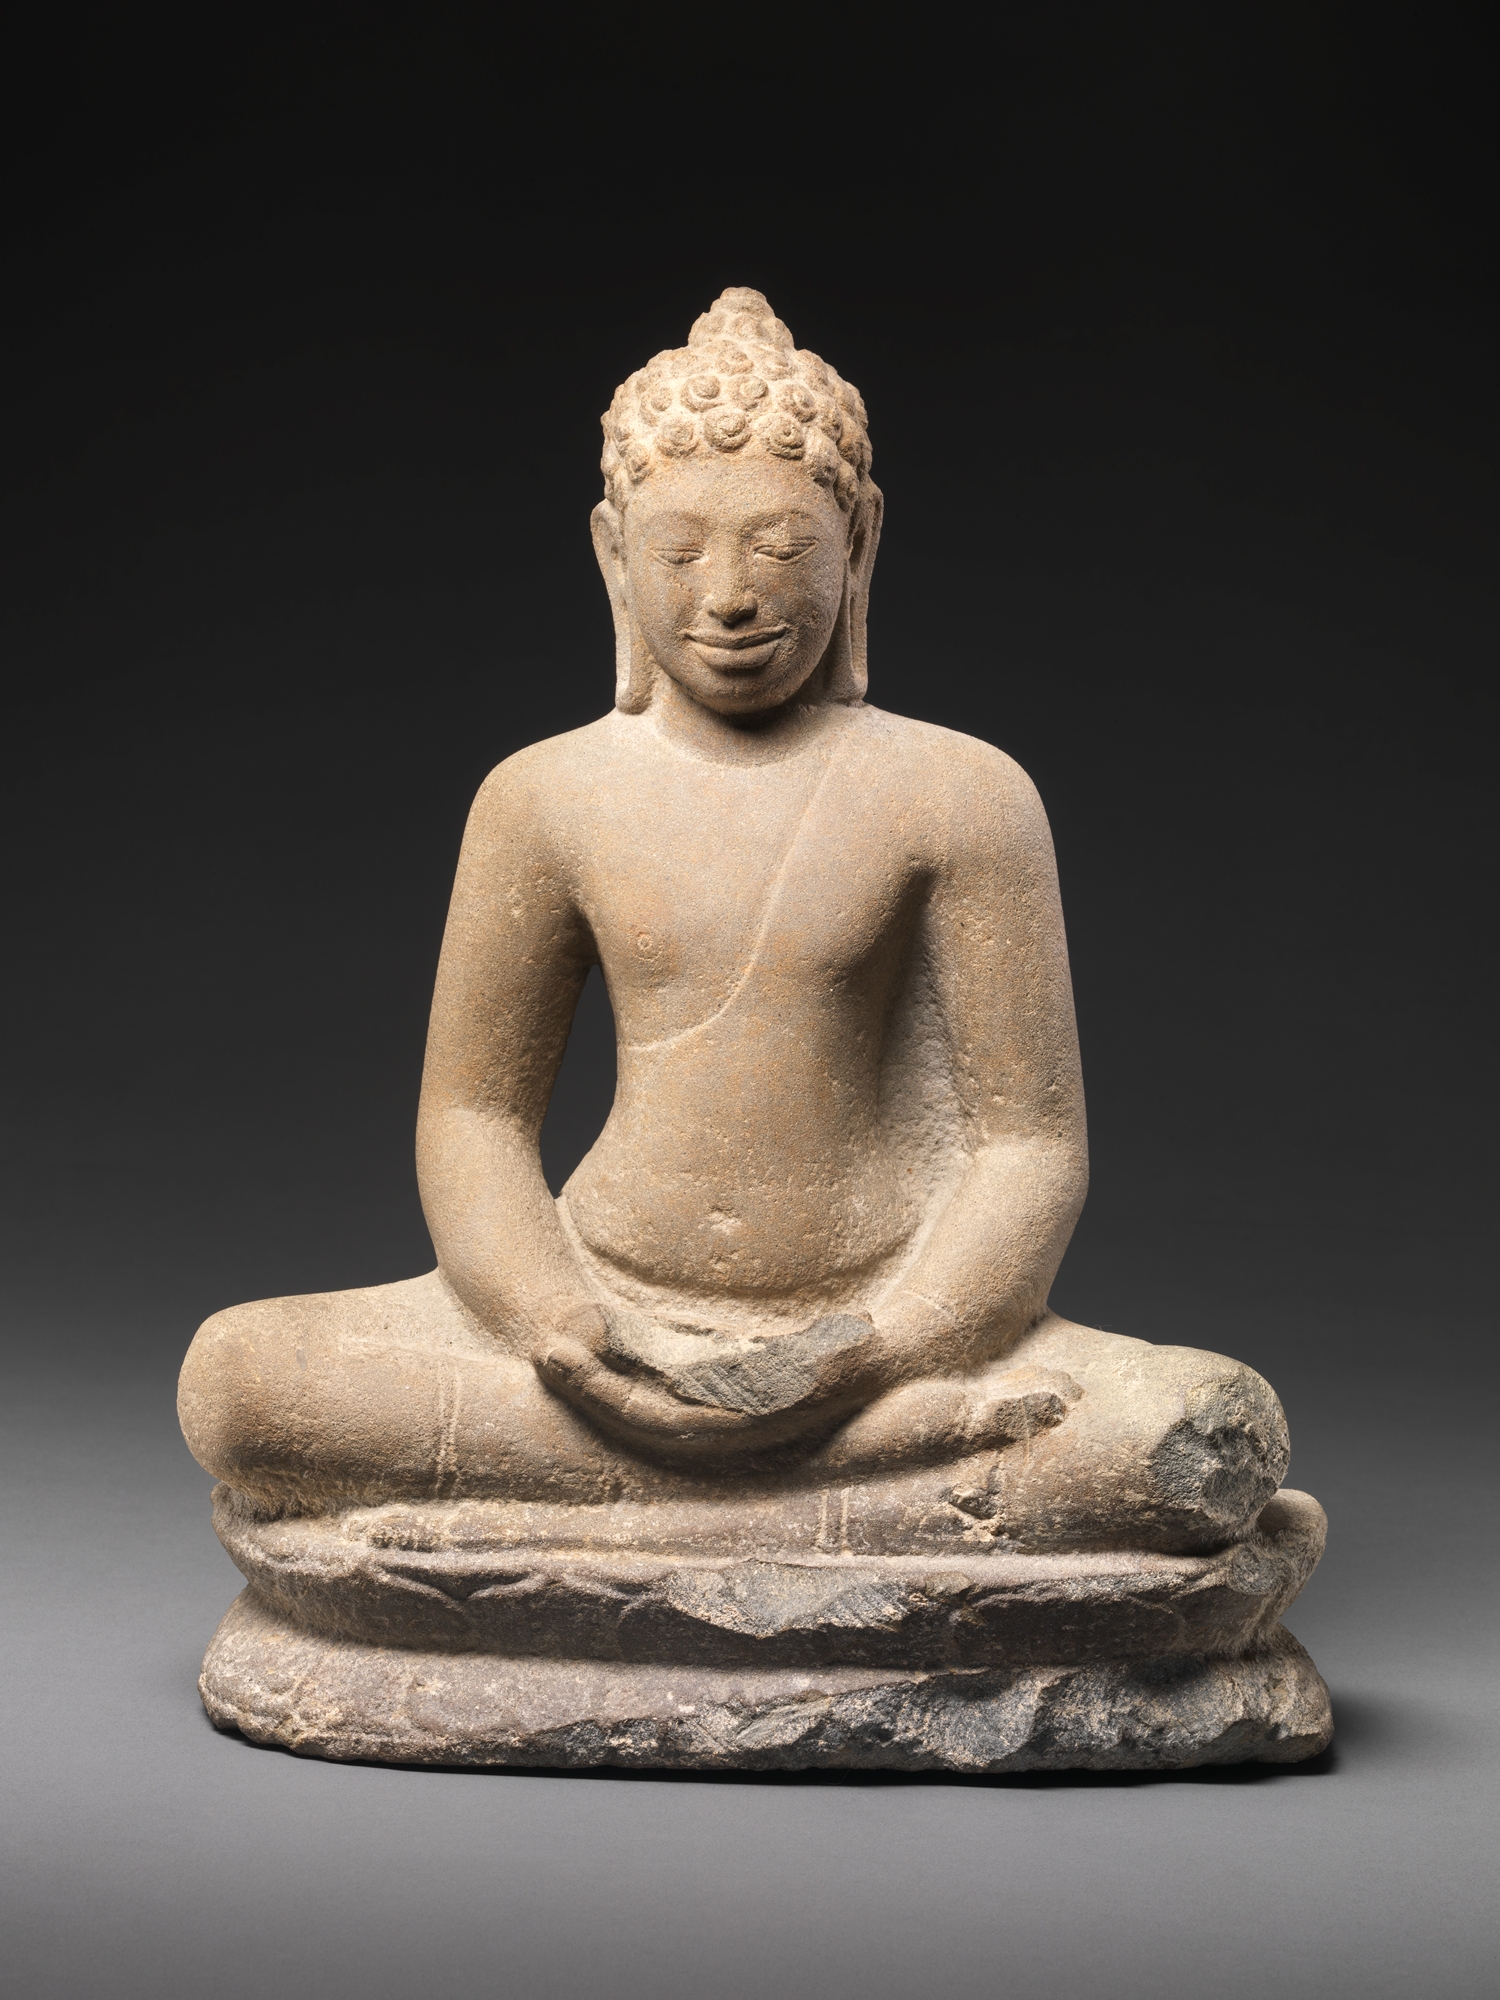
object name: figure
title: Seated Buddha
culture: vietnamese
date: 601-800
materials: stone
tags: buddhism,buddha